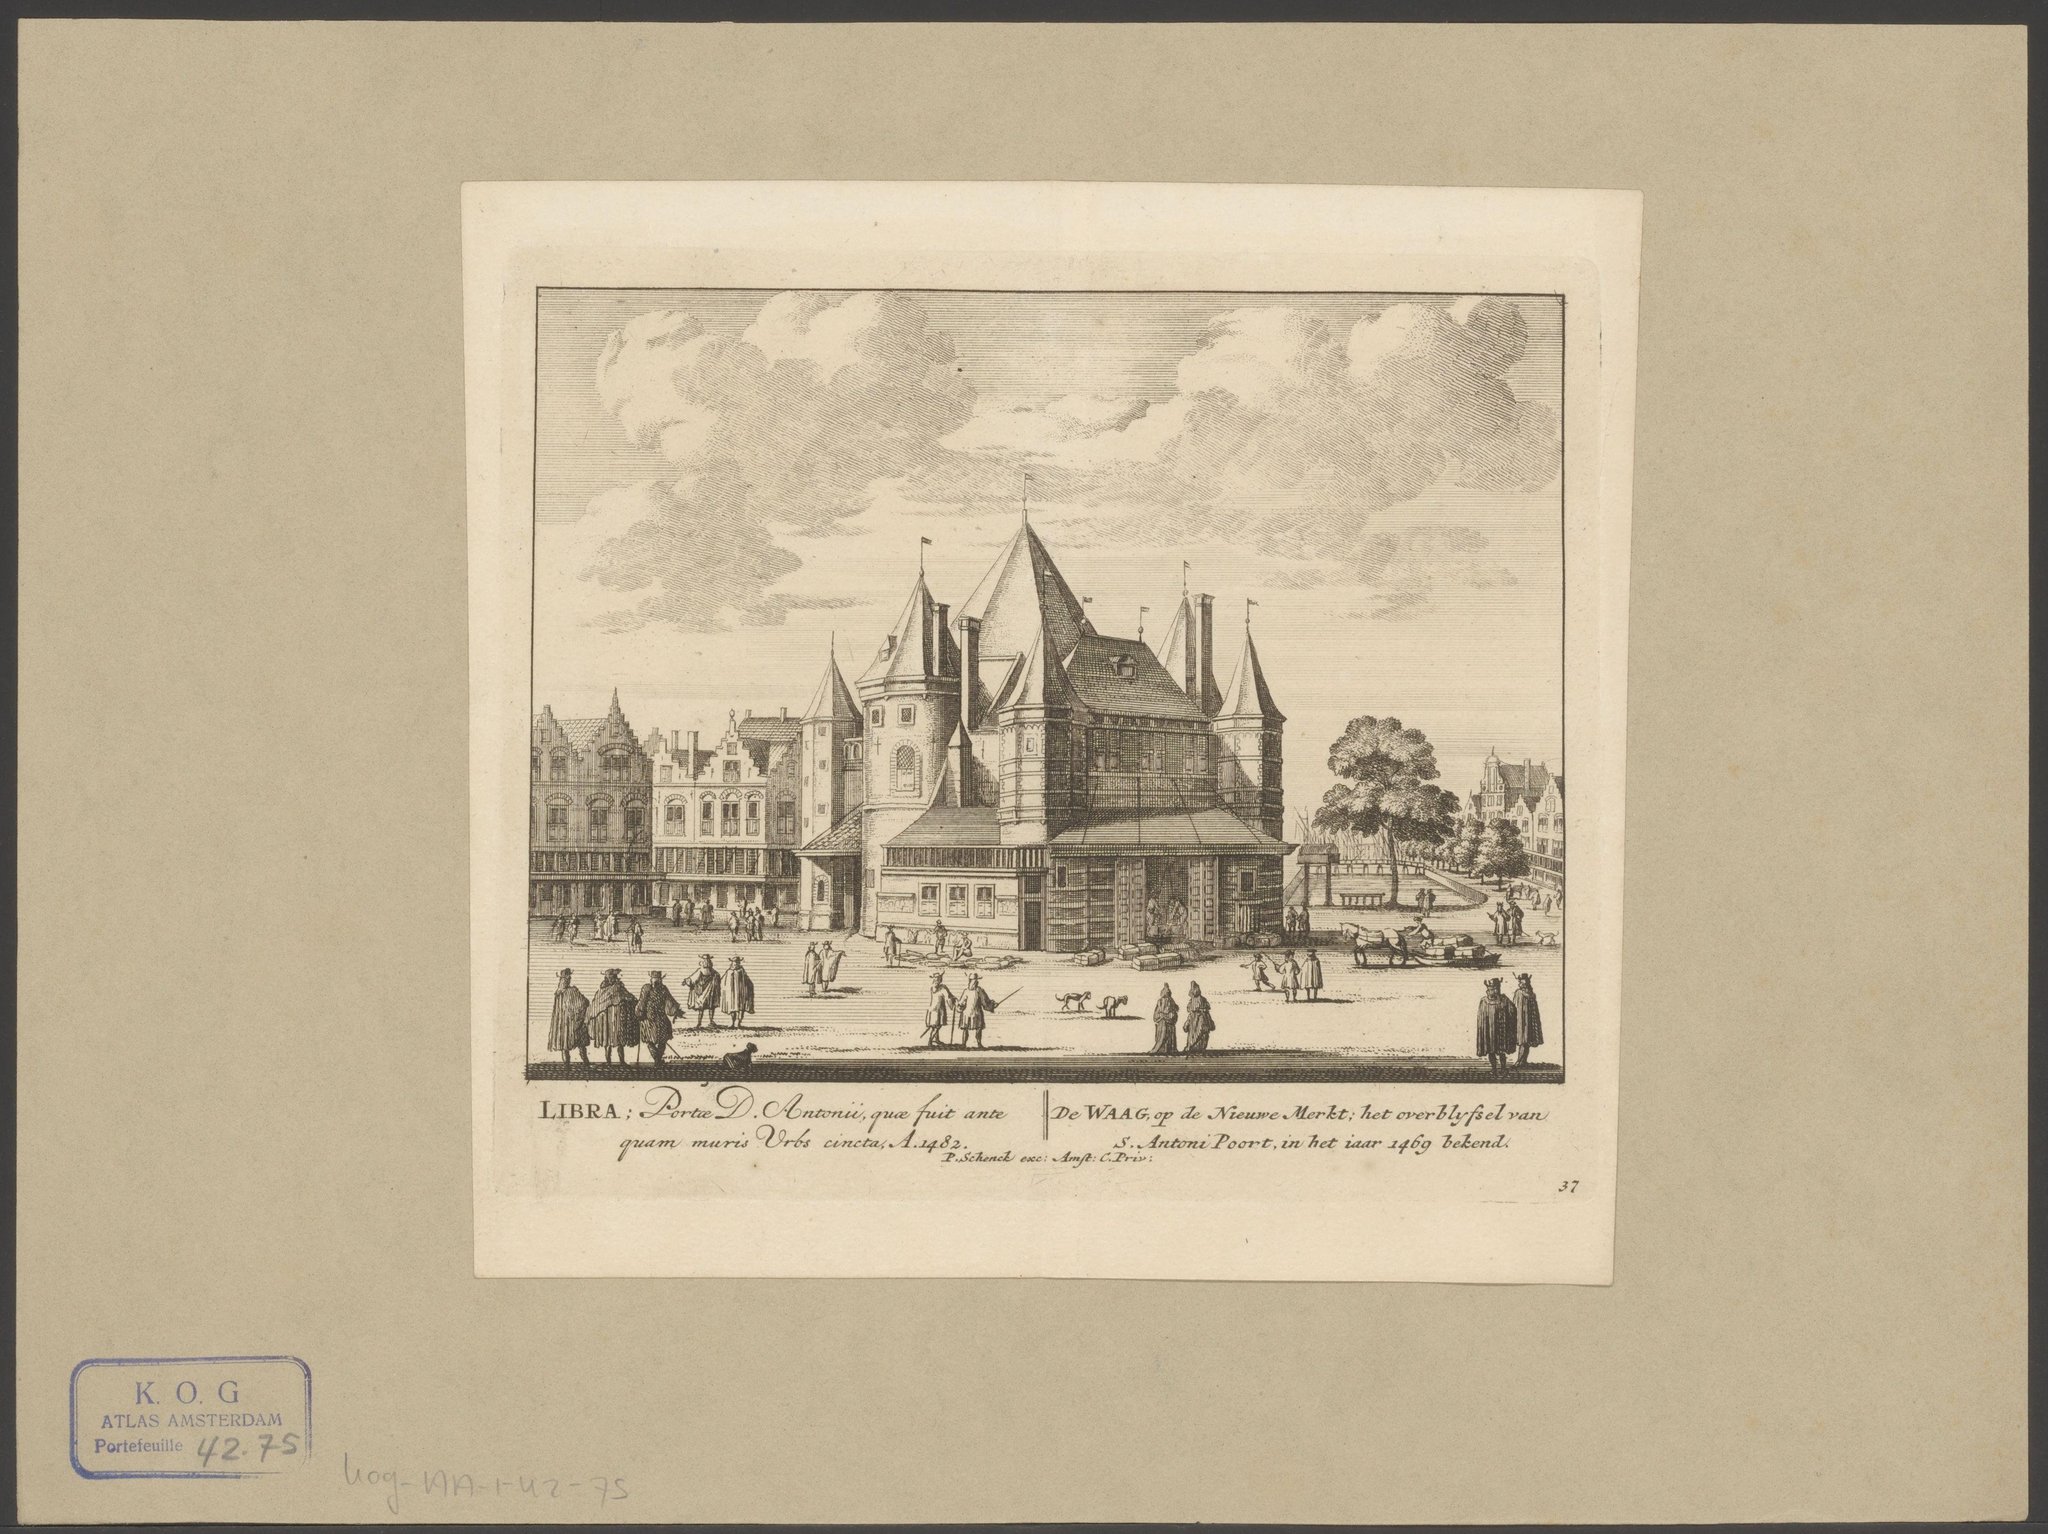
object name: print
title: Gezicht op de Waag op de Nieuwmarkt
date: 1710-1766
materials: paper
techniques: engraving, etching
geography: amsterdam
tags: weigh-house, amsterdam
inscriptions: collector's mark: Lugt 1461b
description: Prent mogelijk uit: 100 Afbeeldinge der voornaamste gebouwen van Amsterdam. Amsterdam, Pieter Schenk (I), s.a. [1710-1711]. En in: 100 Afbeeldinge der voornaamste gebouwen van Amsterdam. Amsterdam, Barent Greve, s.a. [1757-1766].* *In de tweede uitgave, uitgegeven door Barent Greve, is alleen de titelprent aangepast. De overige prenten zijn onveranderd gebleven.